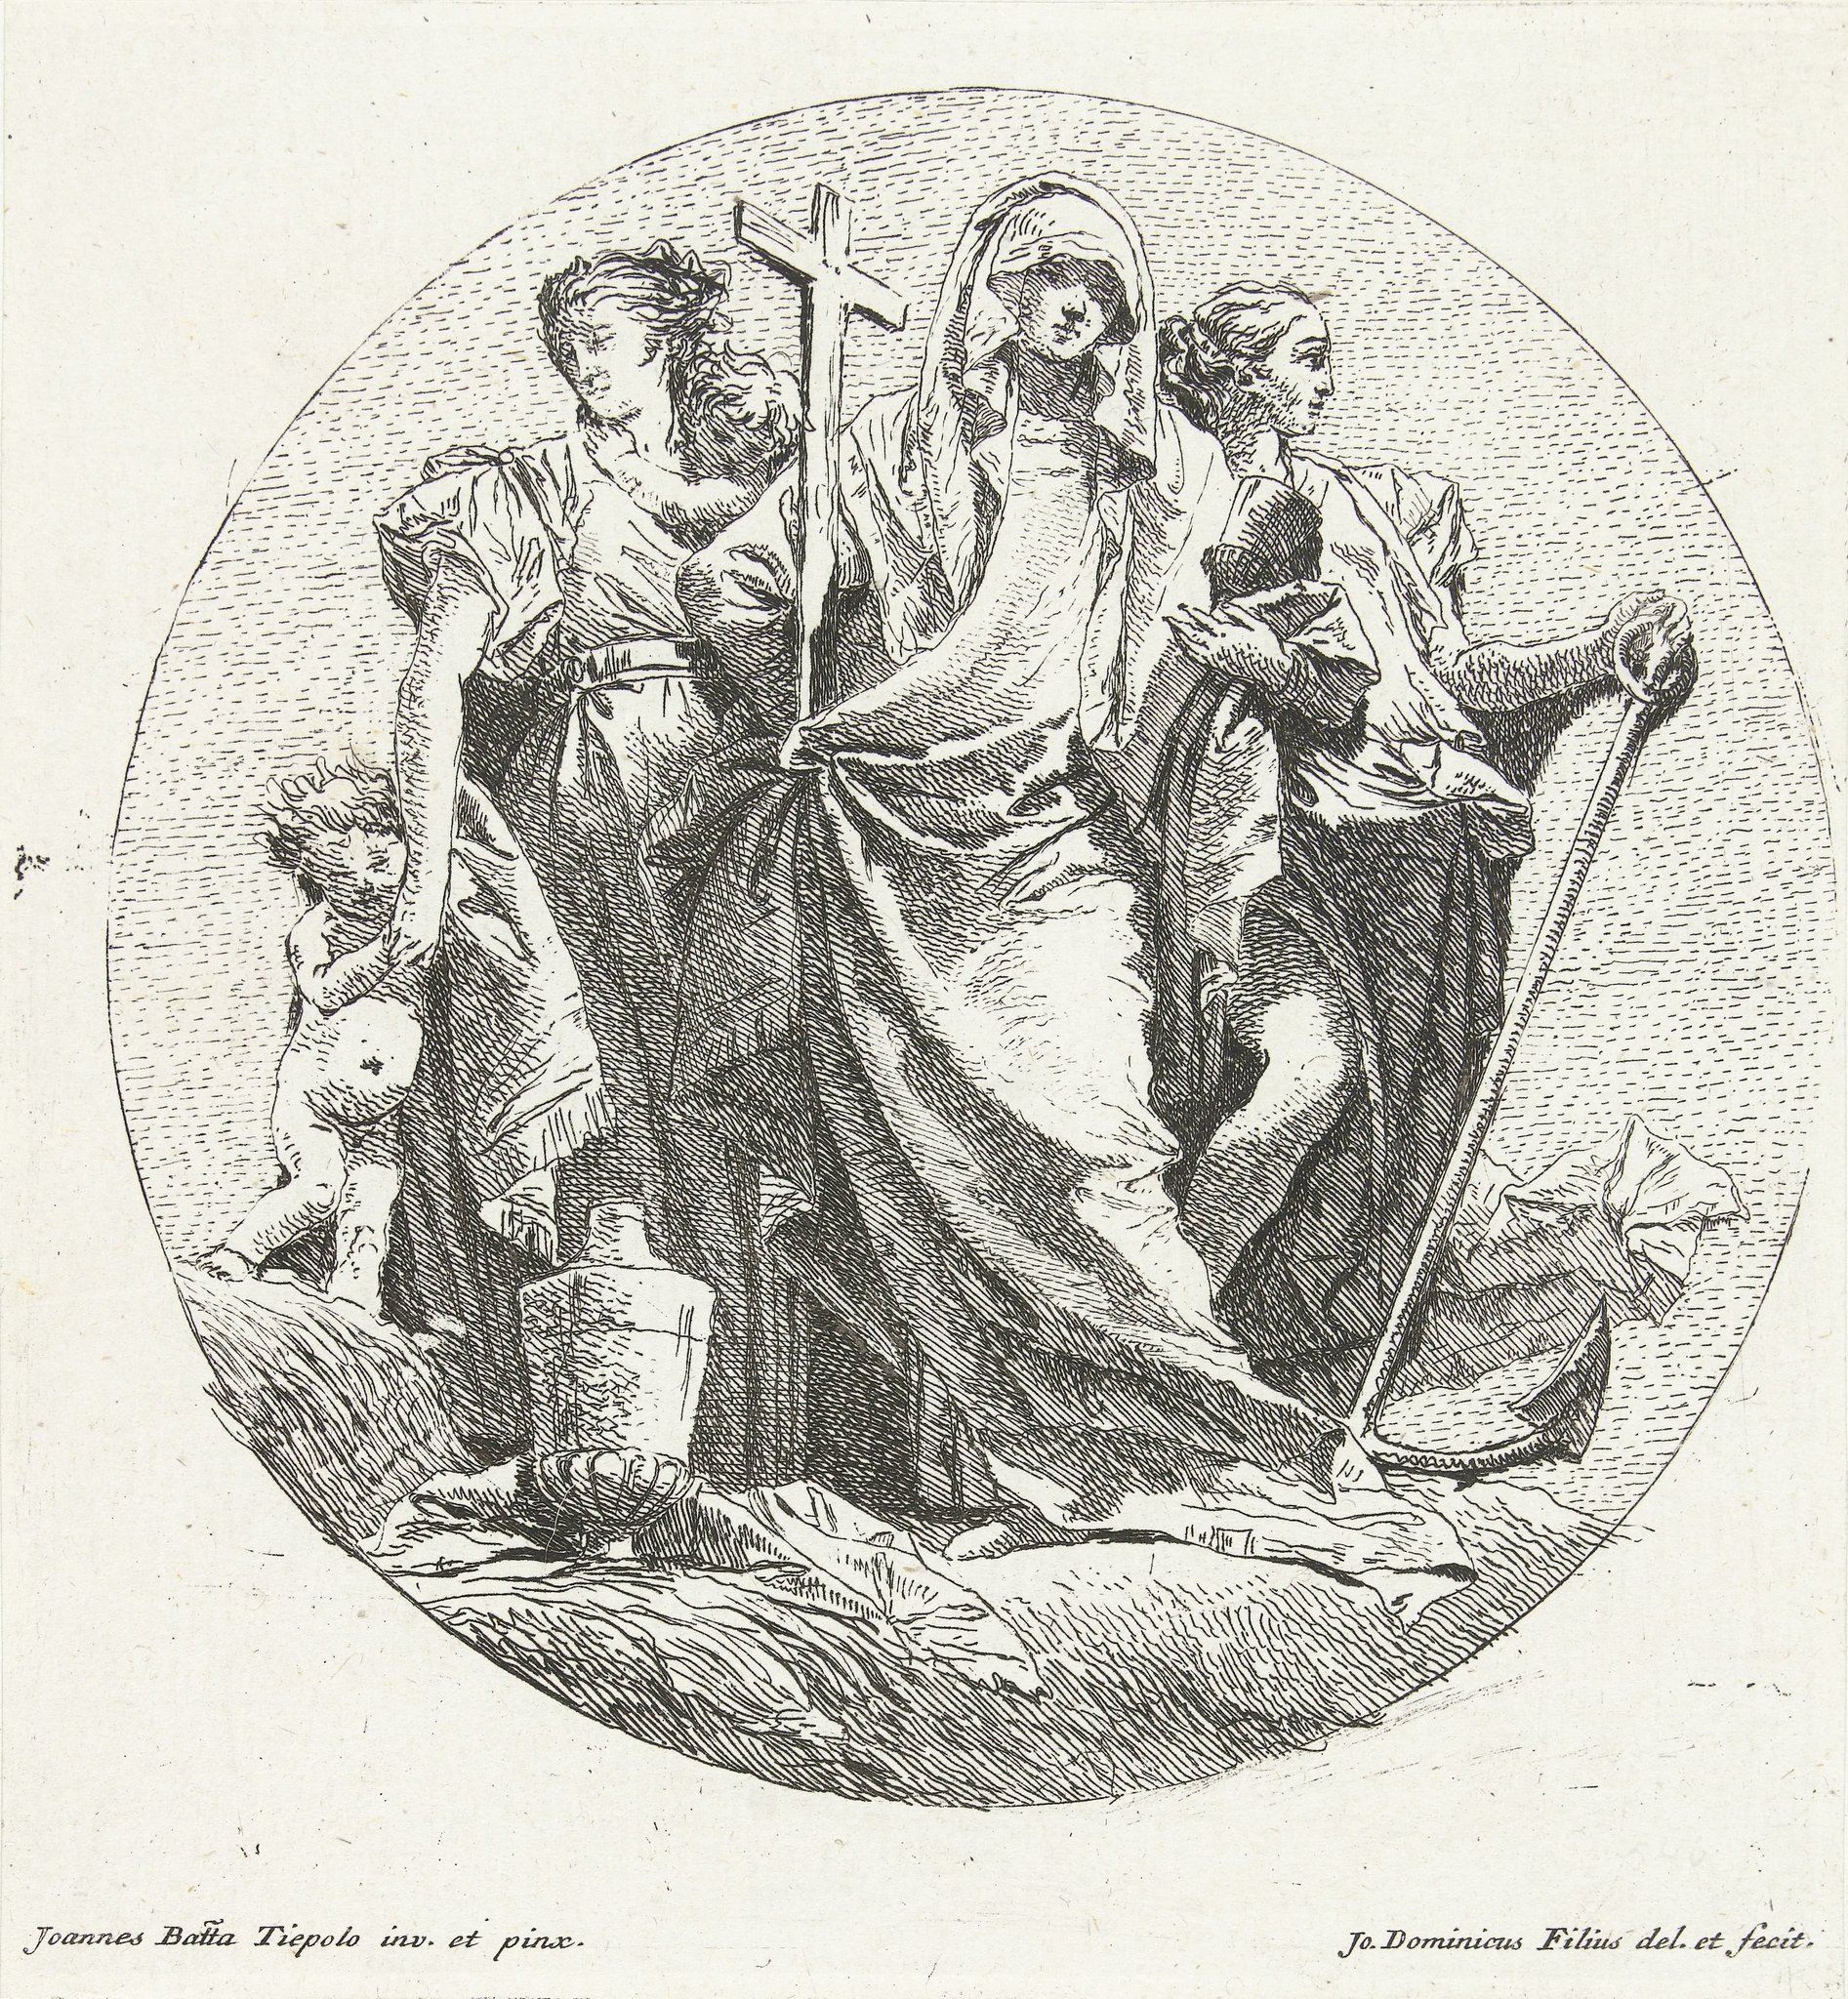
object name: print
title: Drie goddelijke deugden geloof en hoop en liefde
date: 1741-1745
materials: paper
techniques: etching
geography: venice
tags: the three theological virtues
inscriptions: collector's mark: Lugt 2228, collector's mark: Lugt 2760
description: Vrouwelijke personificaties van drie goddelijke deugden: geloof met kruis, hoop met anker en liefde met twee kinderen.